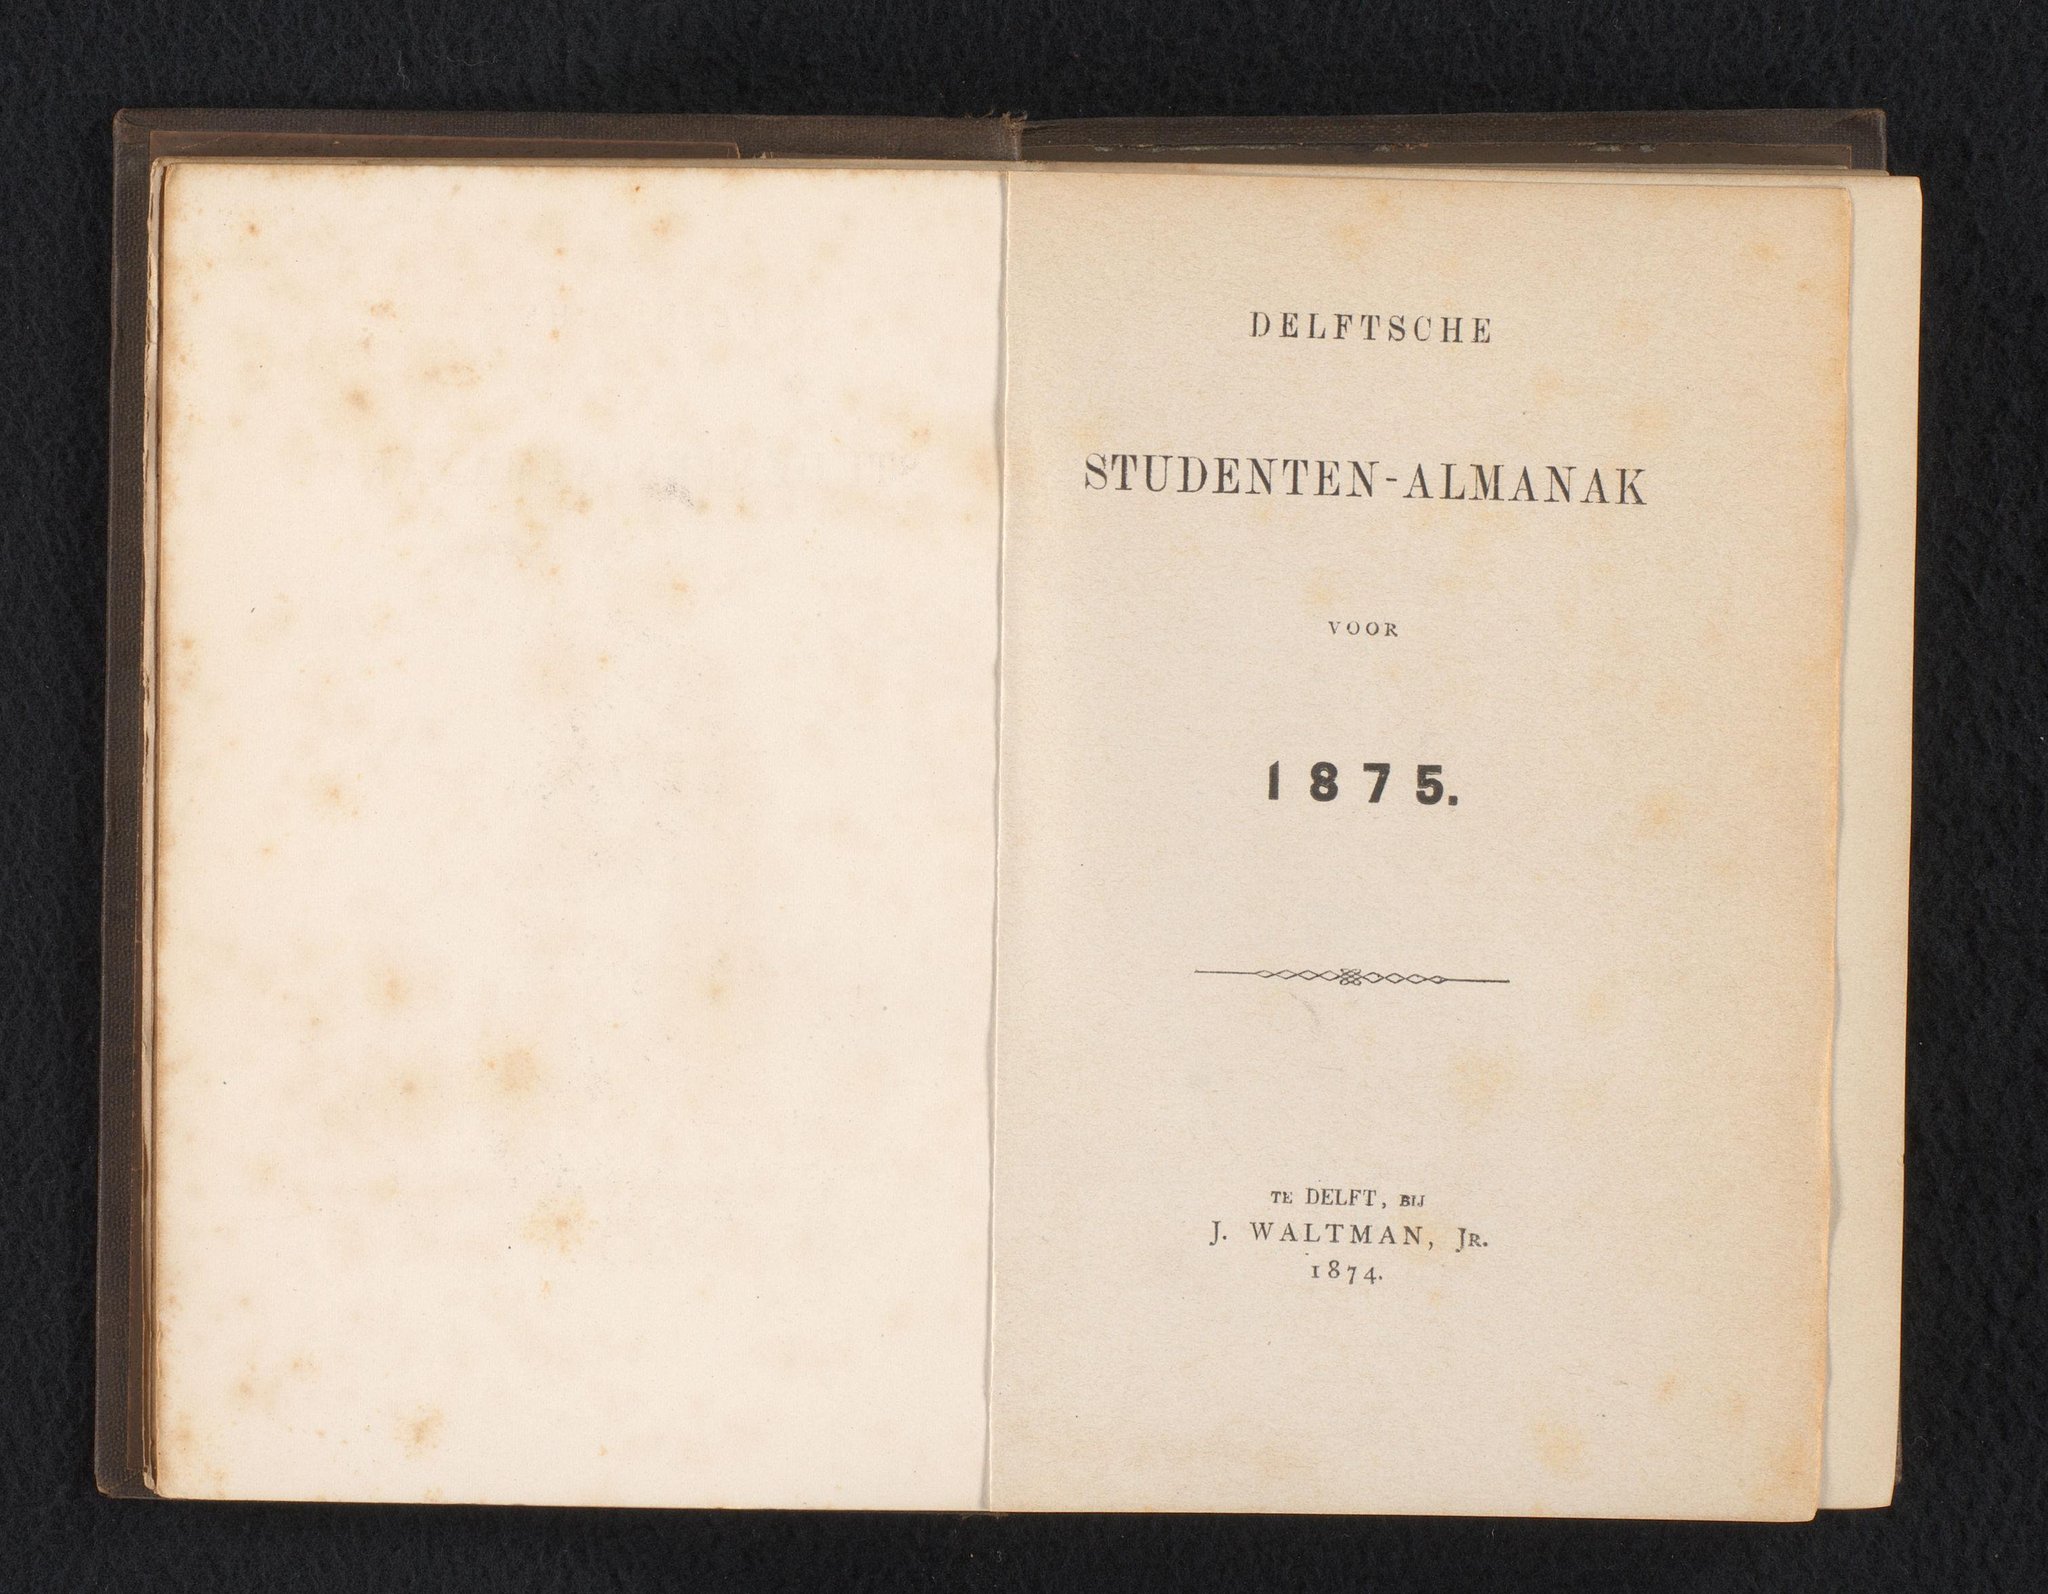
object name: book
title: Delftsche studenten-almanak voor 1875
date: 1874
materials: paper, cardboard, linen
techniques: albumen print, letterpress printing, lithograph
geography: the hague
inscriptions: inscription: ‘J.L. Bienfait’